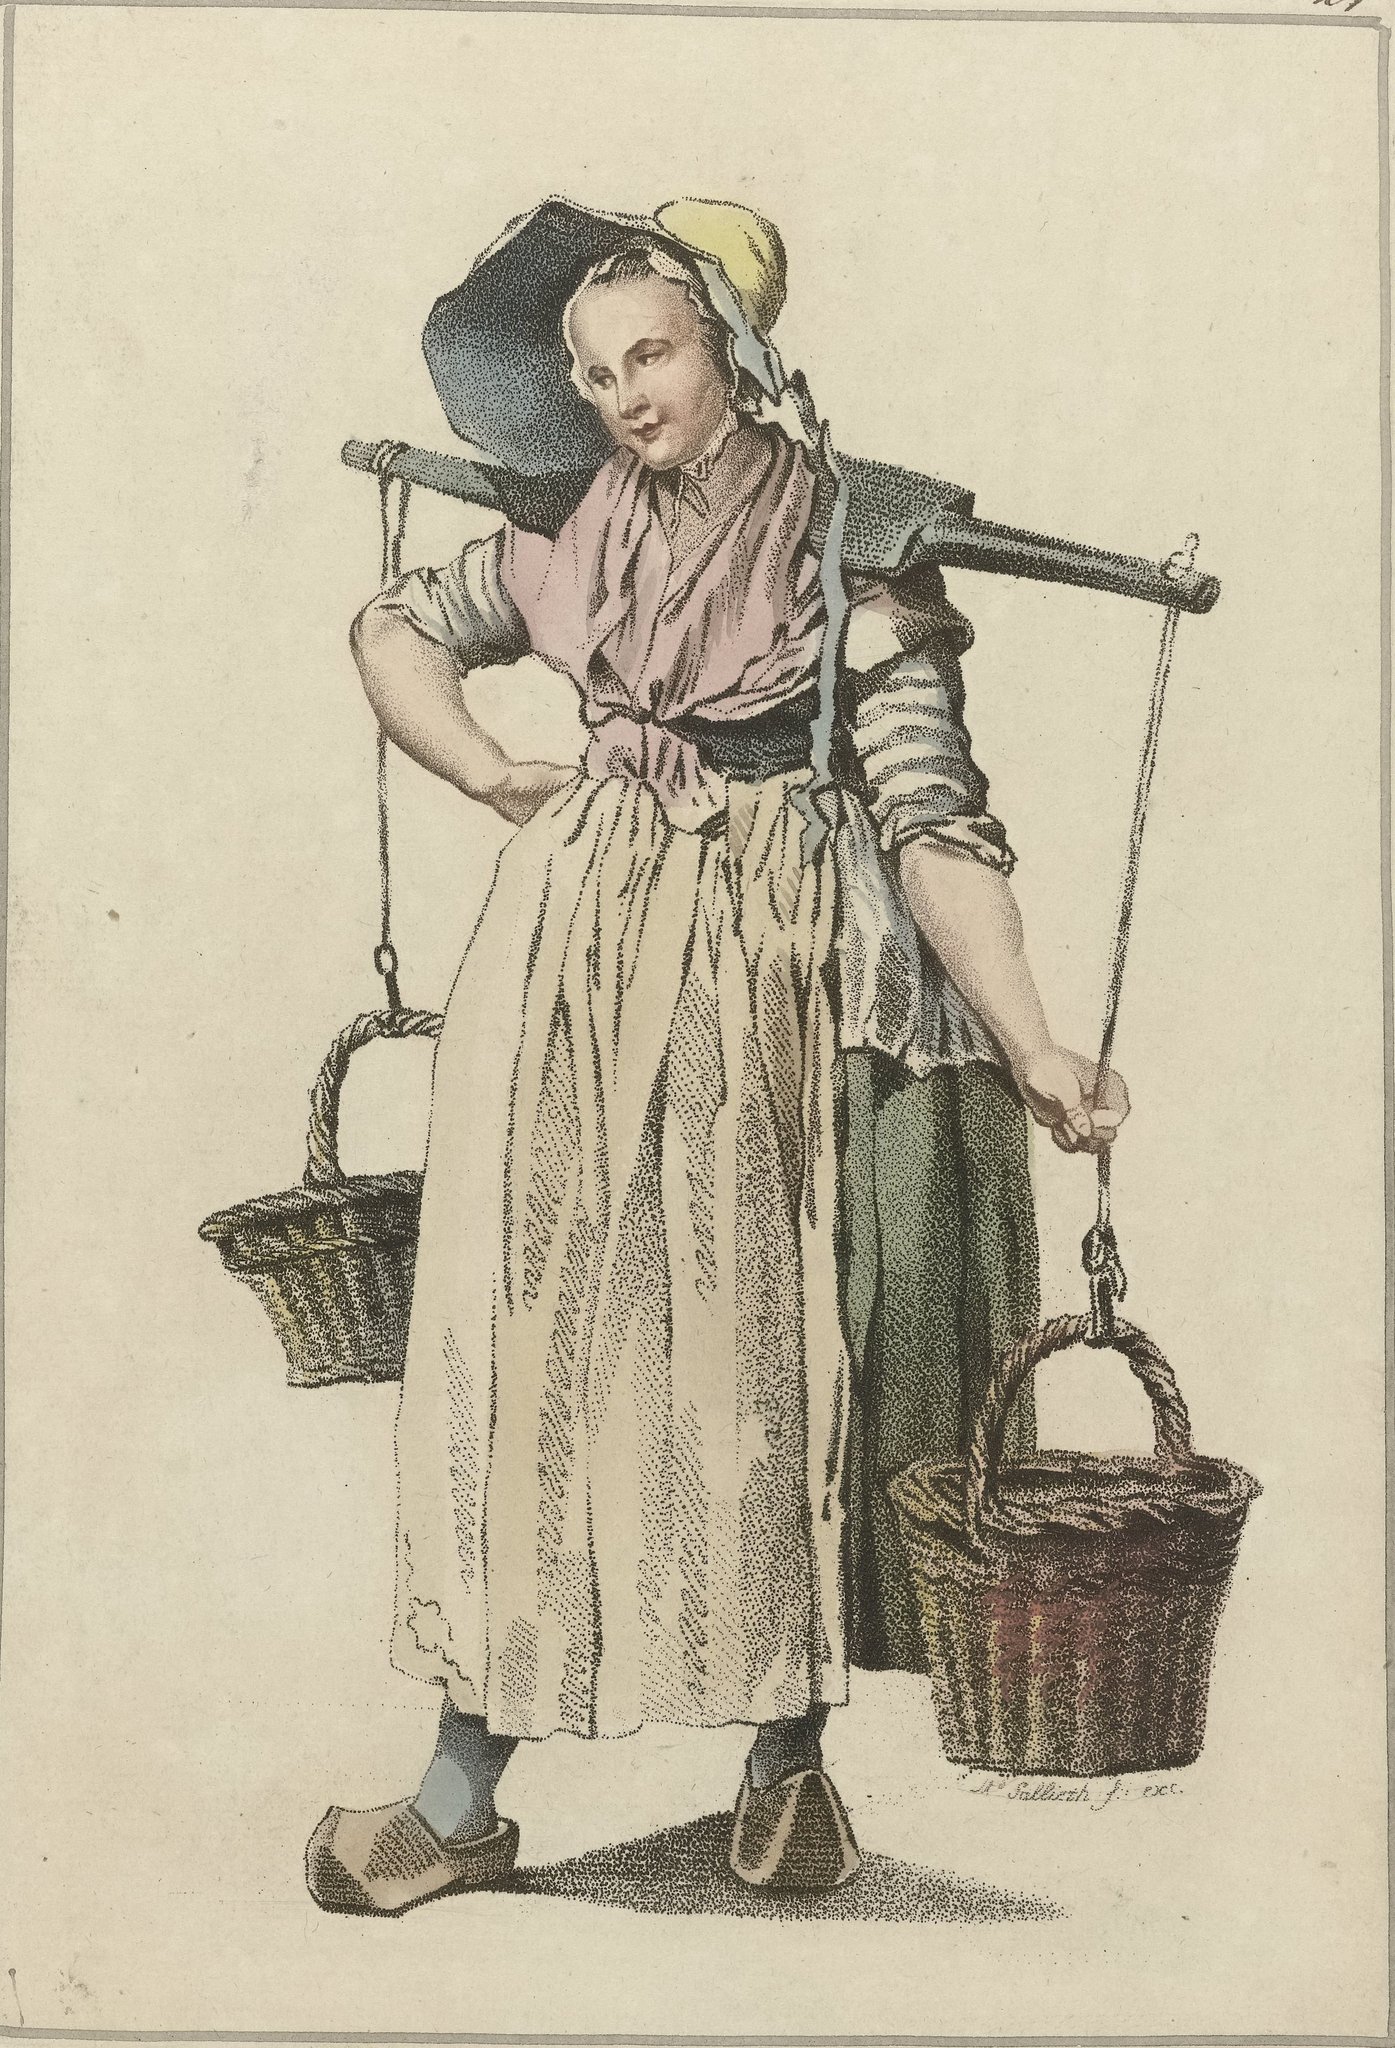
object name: print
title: Boerenvrouw met twee manden aan een juk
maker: mathias de sallieth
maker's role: print maker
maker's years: 1749-1791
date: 1772-1791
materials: paper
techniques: printmaking, etching, hand coloring, lithography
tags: farmers - aa - female farmer, farmer's wife, container made of plant material other than wood: basket, carrying something with yoke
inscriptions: number: ‘N 9 I - 27’, collector's mark: Lugt 2228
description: De prent verscheen vanaf 1818 tevens als onderdeel van een 33-delige reeks prenten door Mathias de Sallieth, samengebonden in: Perkois, Jacobus, Prins, Johannes Huibert. Verzameling van verschillende gekleede mans- en vrouwenstanden, ter oefening van jonge schilders en liefhebbers. Rotterdam: Johannes Immerzeel, 1818.